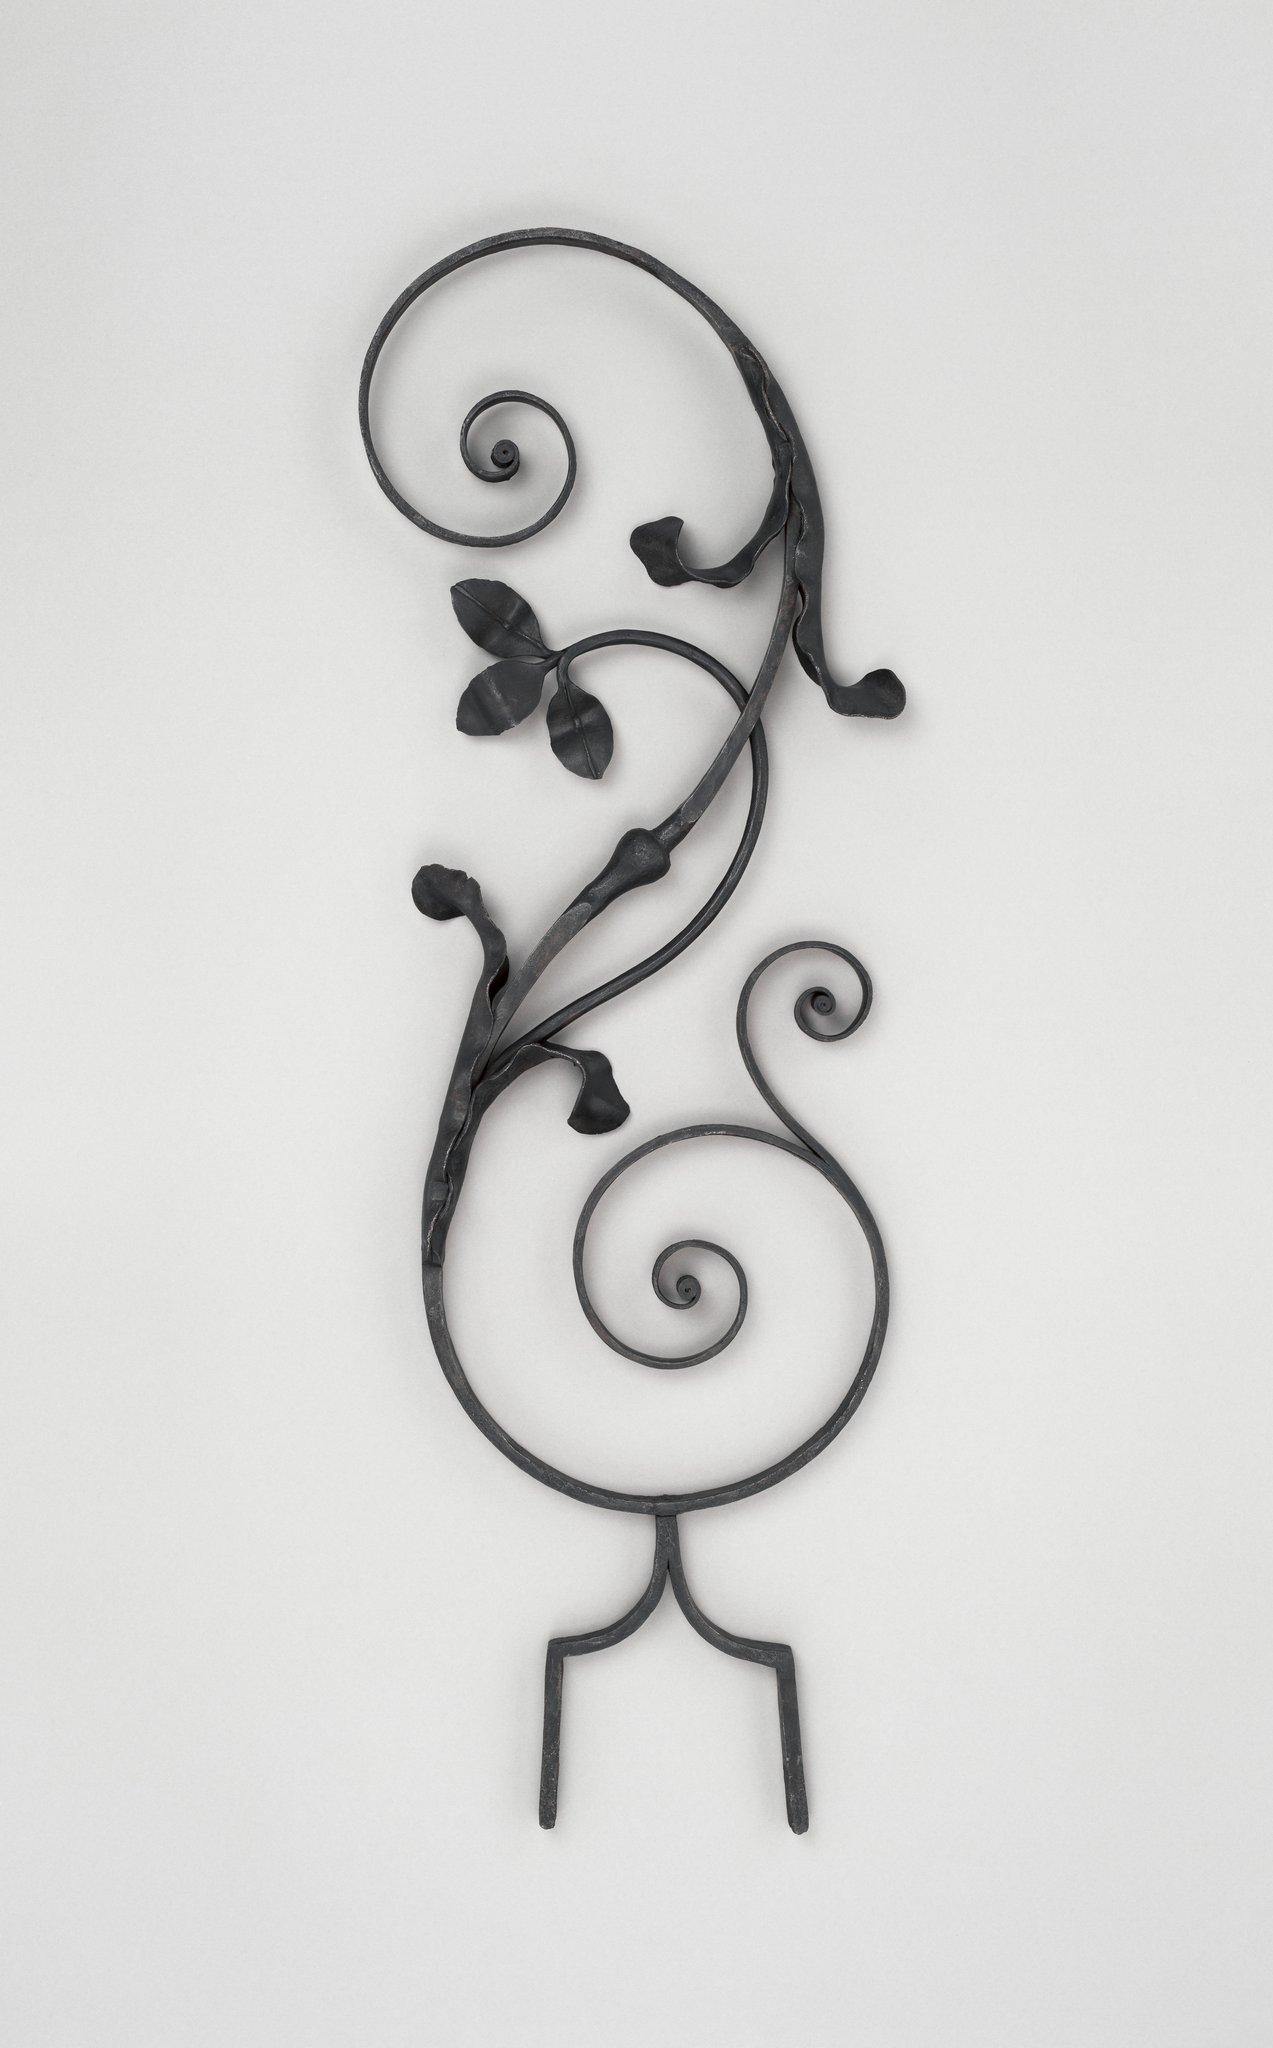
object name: baluster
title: Iron baluster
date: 1750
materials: iron